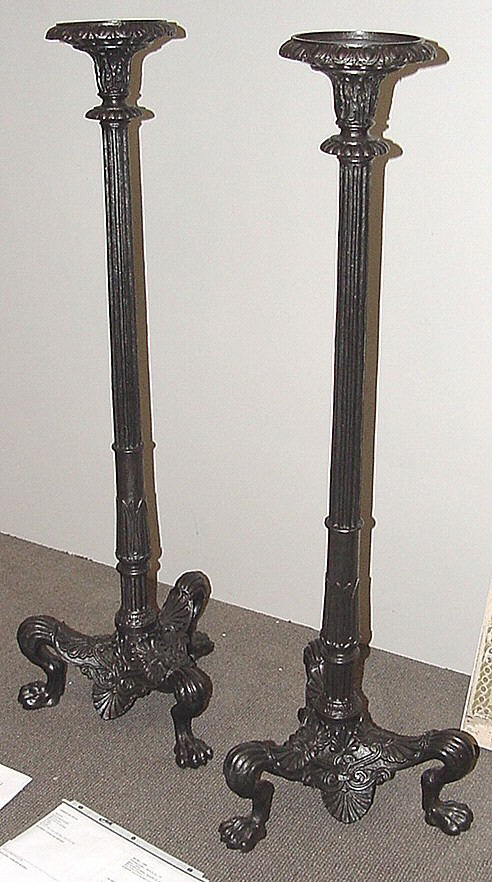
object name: torchères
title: Pair of torchères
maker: karl friedrich schinkel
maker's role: artist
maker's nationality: german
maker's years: 1781-1841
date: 1820-1830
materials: iron